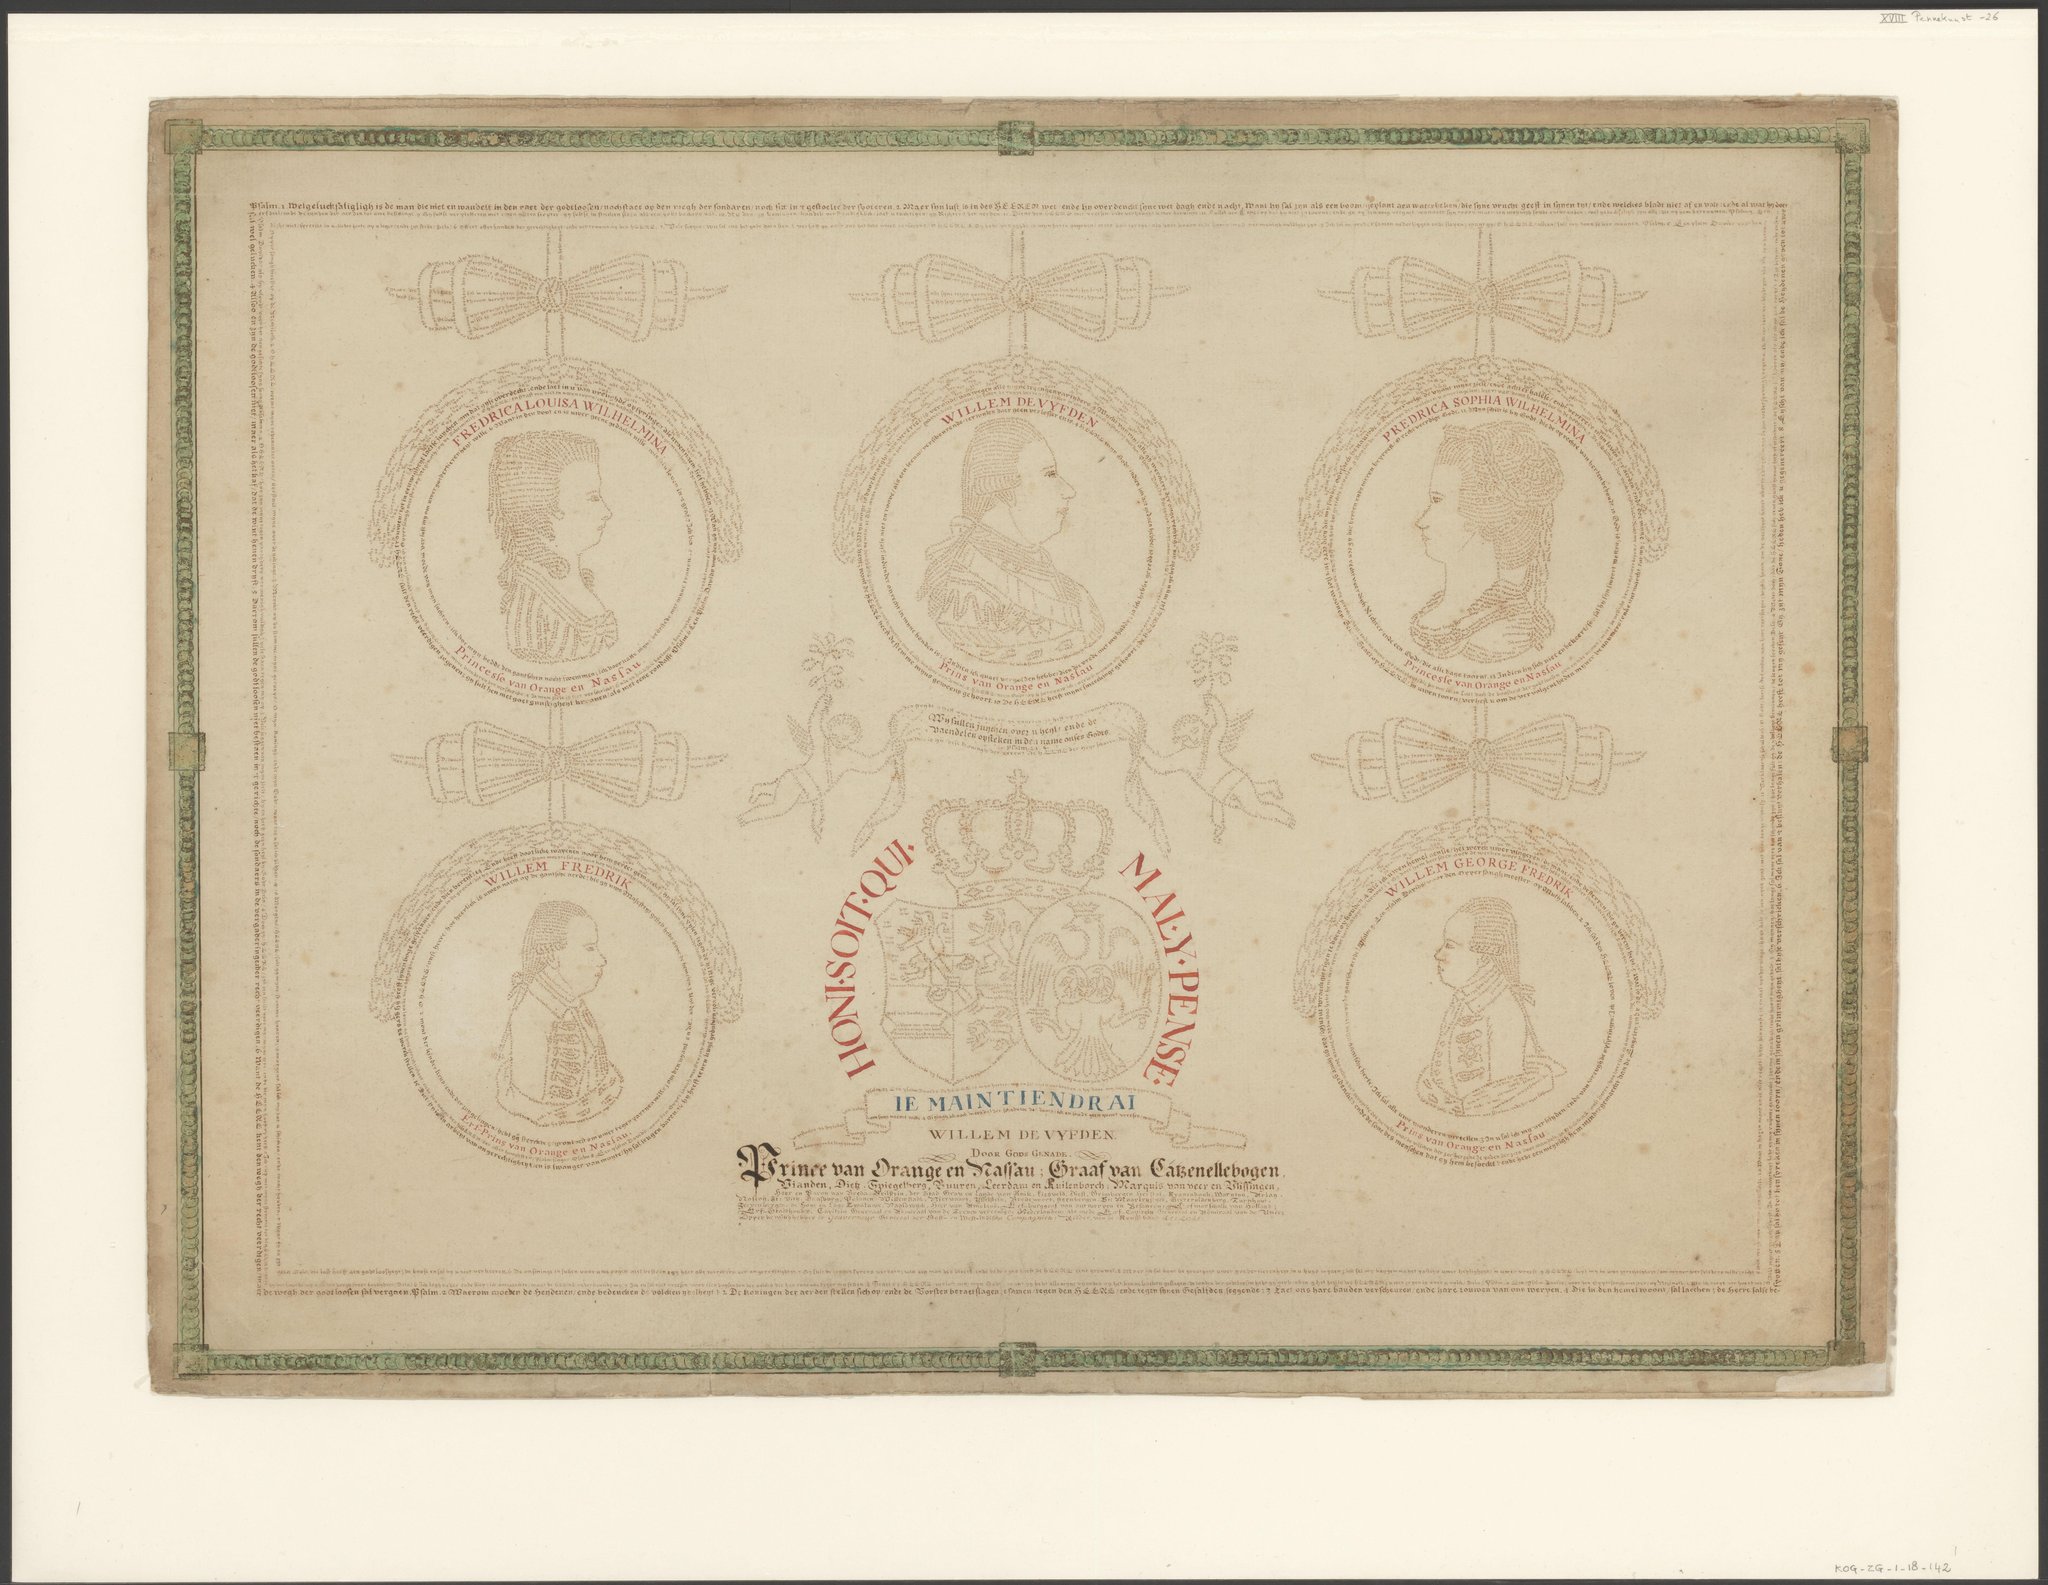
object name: calligraphy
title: Kalligrafie op Willem V, prins van Oranje-Nassau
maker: Anonymous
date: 1791-1849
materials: ink, paper, watercolor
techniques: pen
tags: the hague, william v (prince of orange), william i of the netherlands, draughtsman, wilhelmina of prussia (princess of orange), willem george frederik (prins van oranje-nassau), berlin, wilhelmina frederica louisa (koningin der nederlanden), historical persons - bb - woman, prince, queen, empress, etc. (wife of a ruler), historical persons, ruler, sovereign, calligraphy, crown prince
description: Gekalligrafeerde portretten van Willem V, prins van Oranje-Nassau, Wilhelmina van Pruisen (1774-1837), Wilhelmina van Pruisen (1751-1820), Willem George Frederik, prins van Oranje-Nassau, Willem I, koning der Nederlanden. Onderwerpsrubrieken binnen de Atlas Zeden en Gewoonten: Schoone kunsten, Pennekunst.